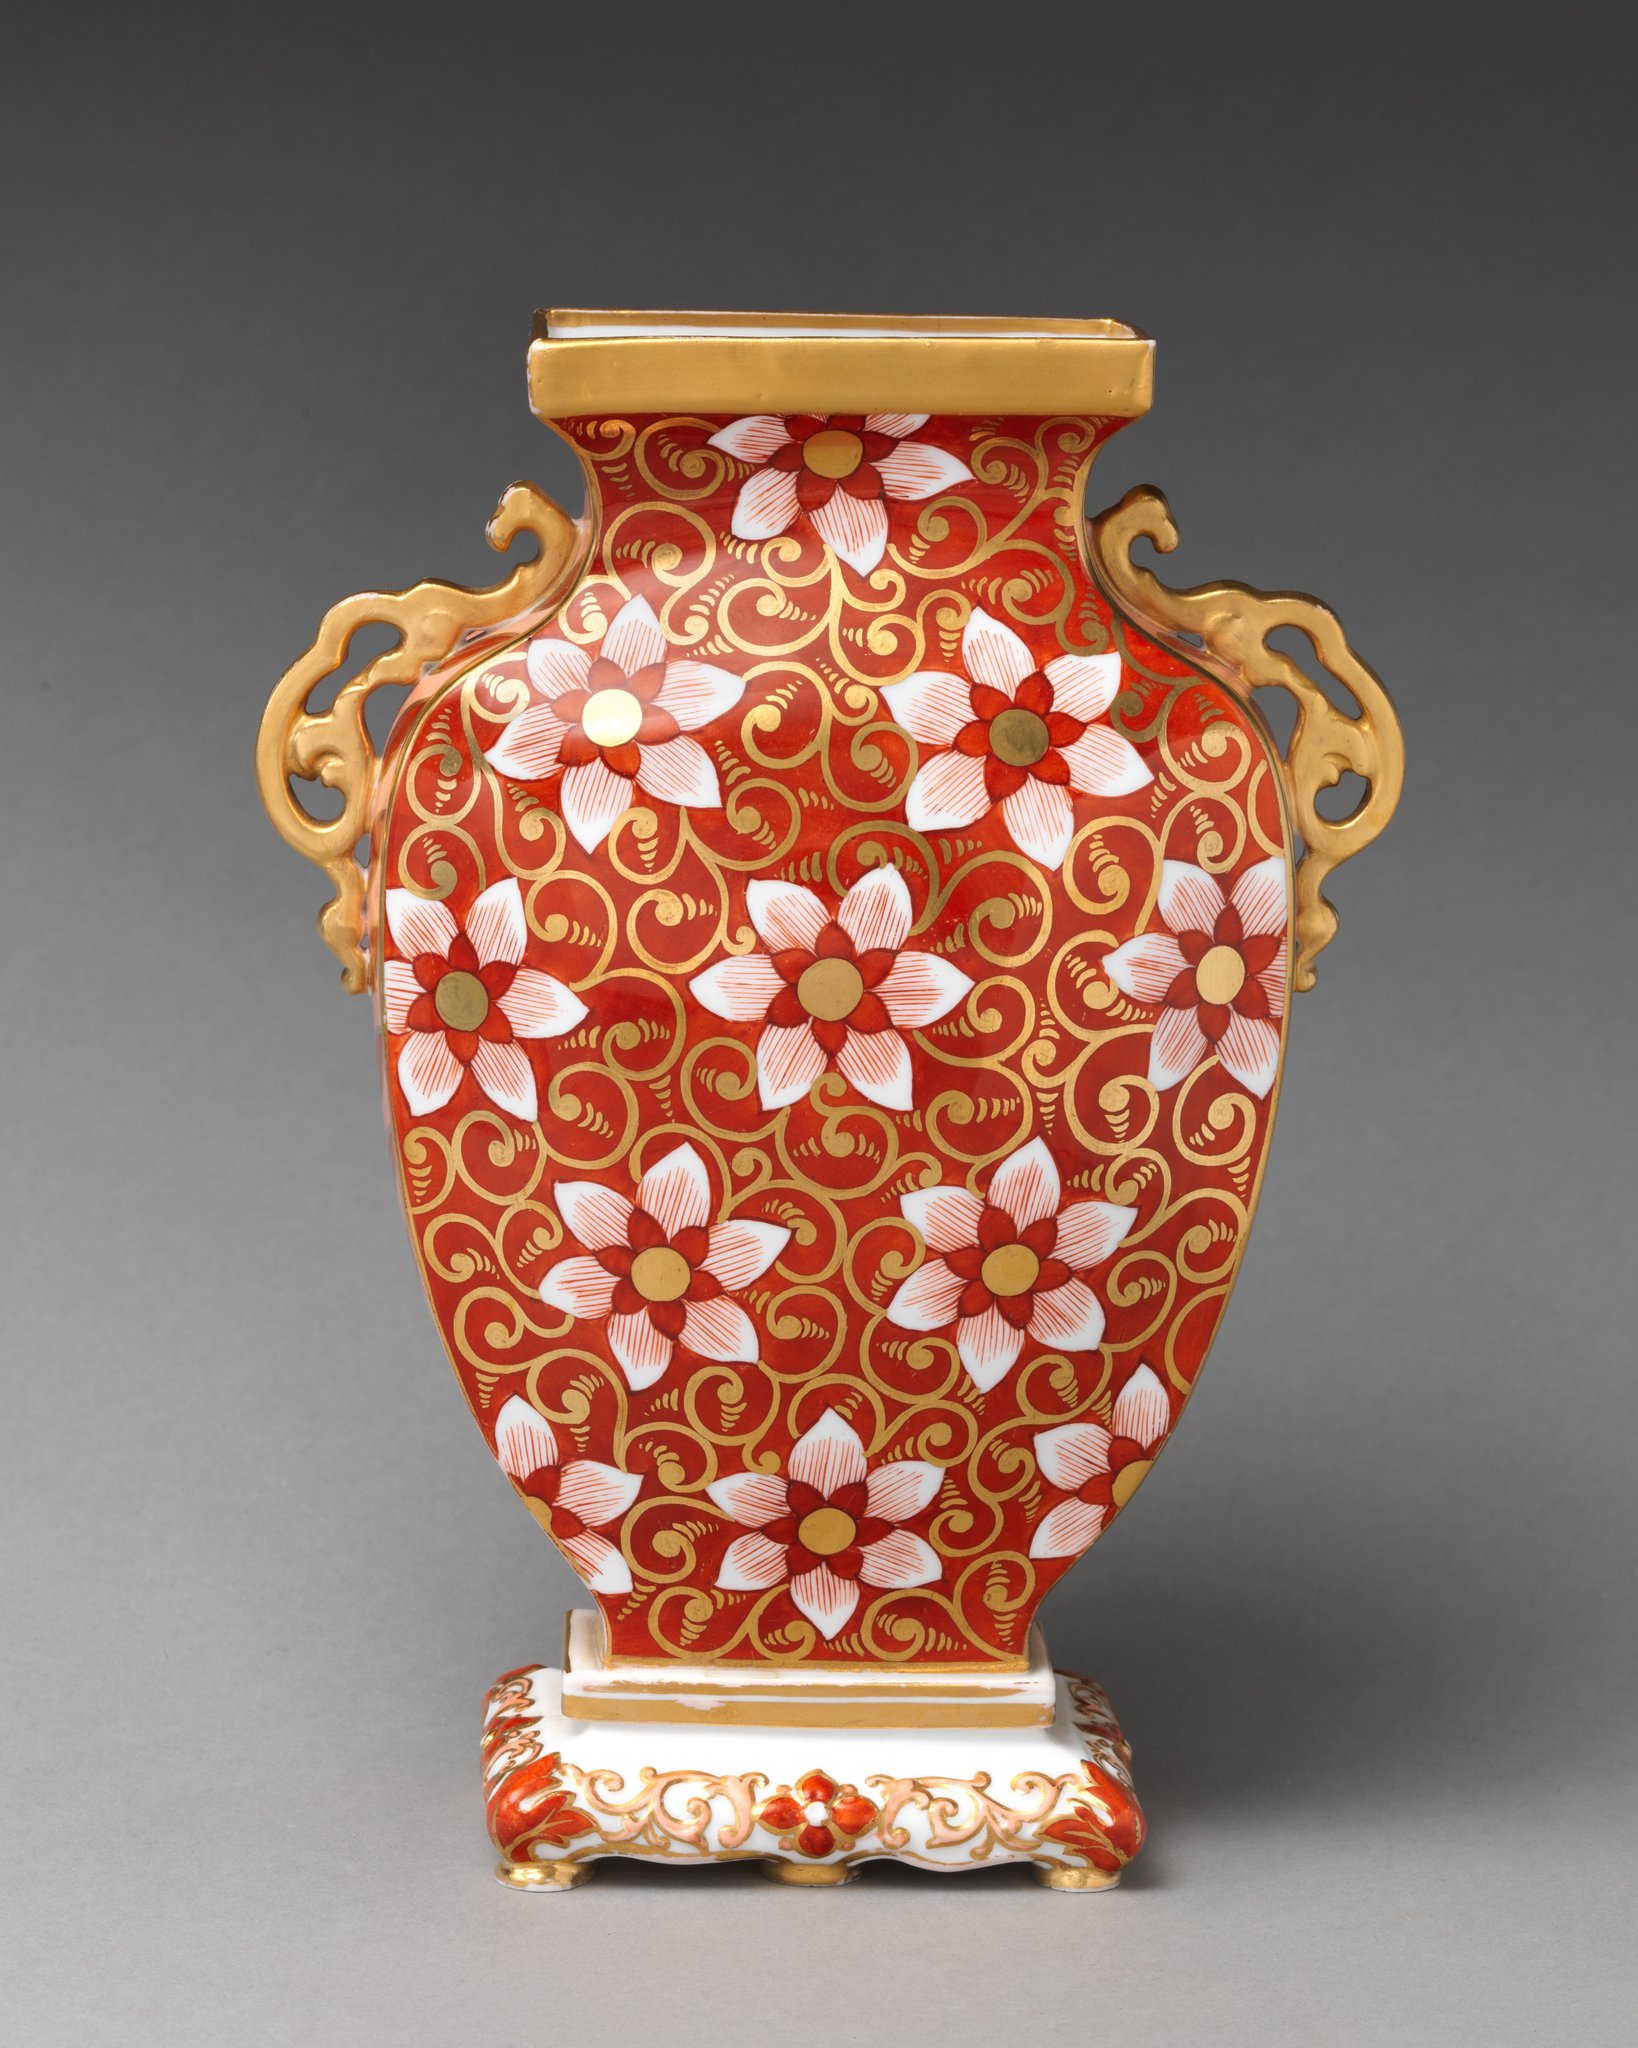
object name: vase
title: Vase (one of a pair)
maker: copeland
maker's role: maker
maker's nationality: british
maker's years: 1833-1970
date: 1891-1900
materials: bone china, enamel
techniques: gilding